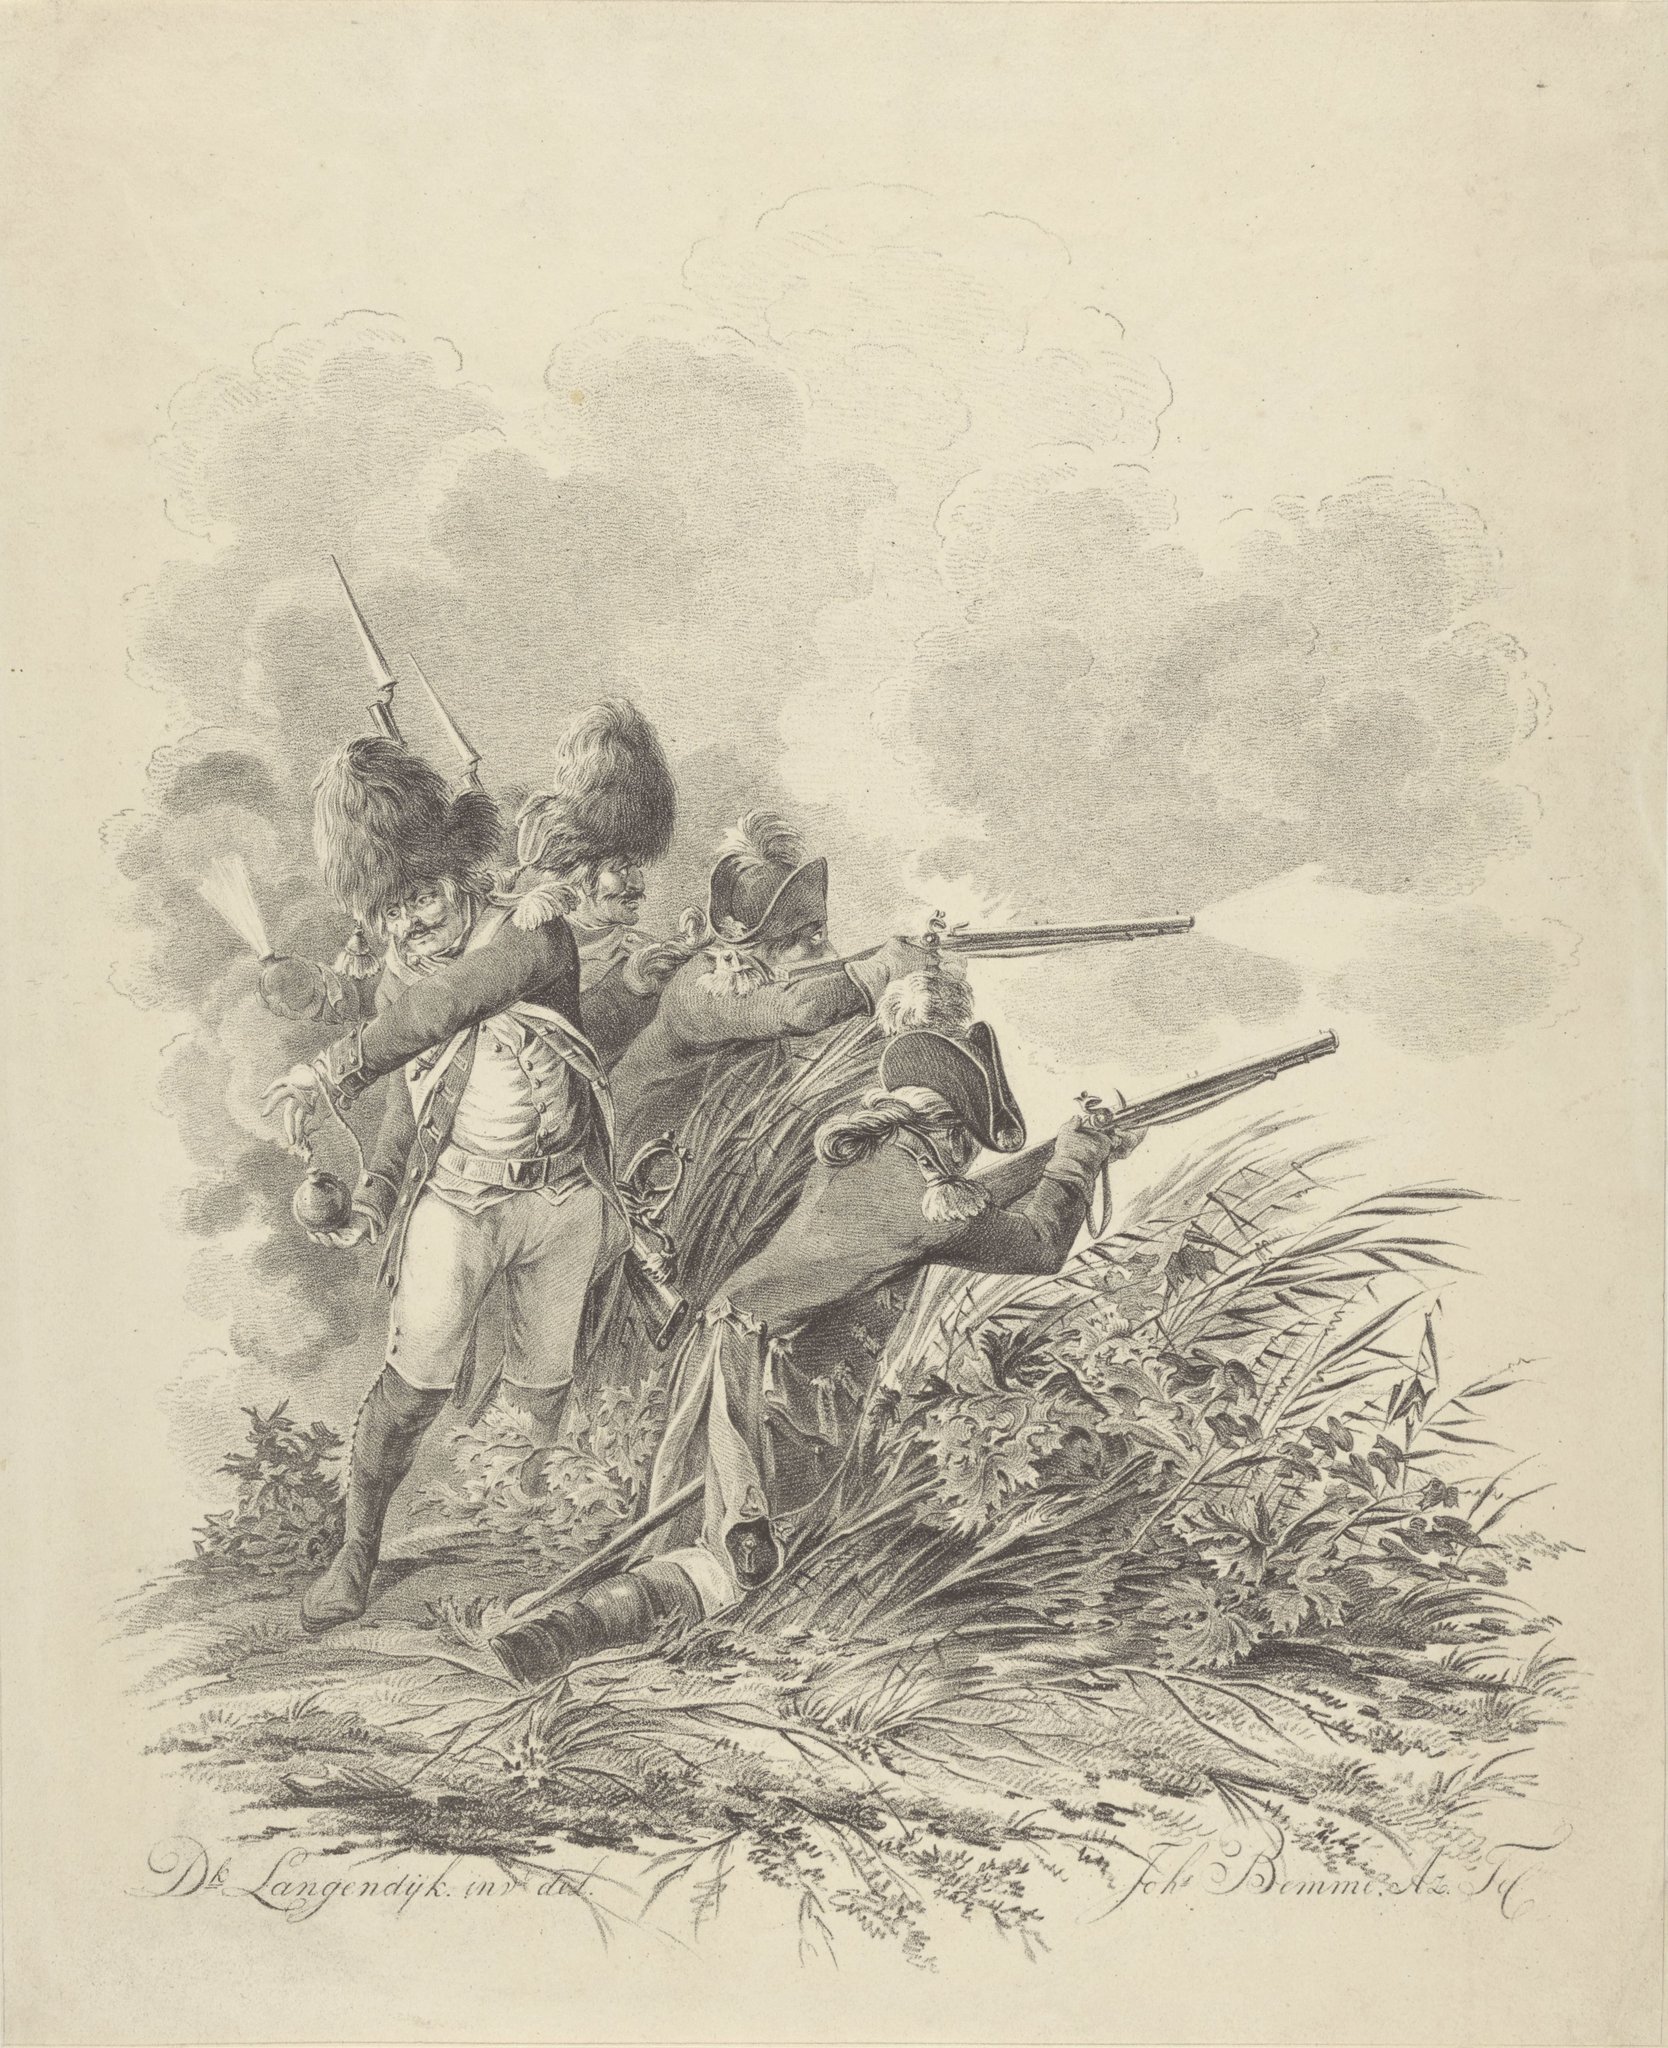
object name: print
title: Soldaten in gevecht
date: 1809-1841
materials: paper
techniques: lithograph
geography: rotterdam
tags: violent death by bomb, hand-grenade, firearms (+ during the battle)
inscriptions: collector's mark: Lugt 2228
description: Een groepje soldaten heeft zich verzameld achter struikgewas. Twee van hen schieten, een derde kijkt over hun schouders mee. De vierde staat achter hen en steekt een handgranaat aan.